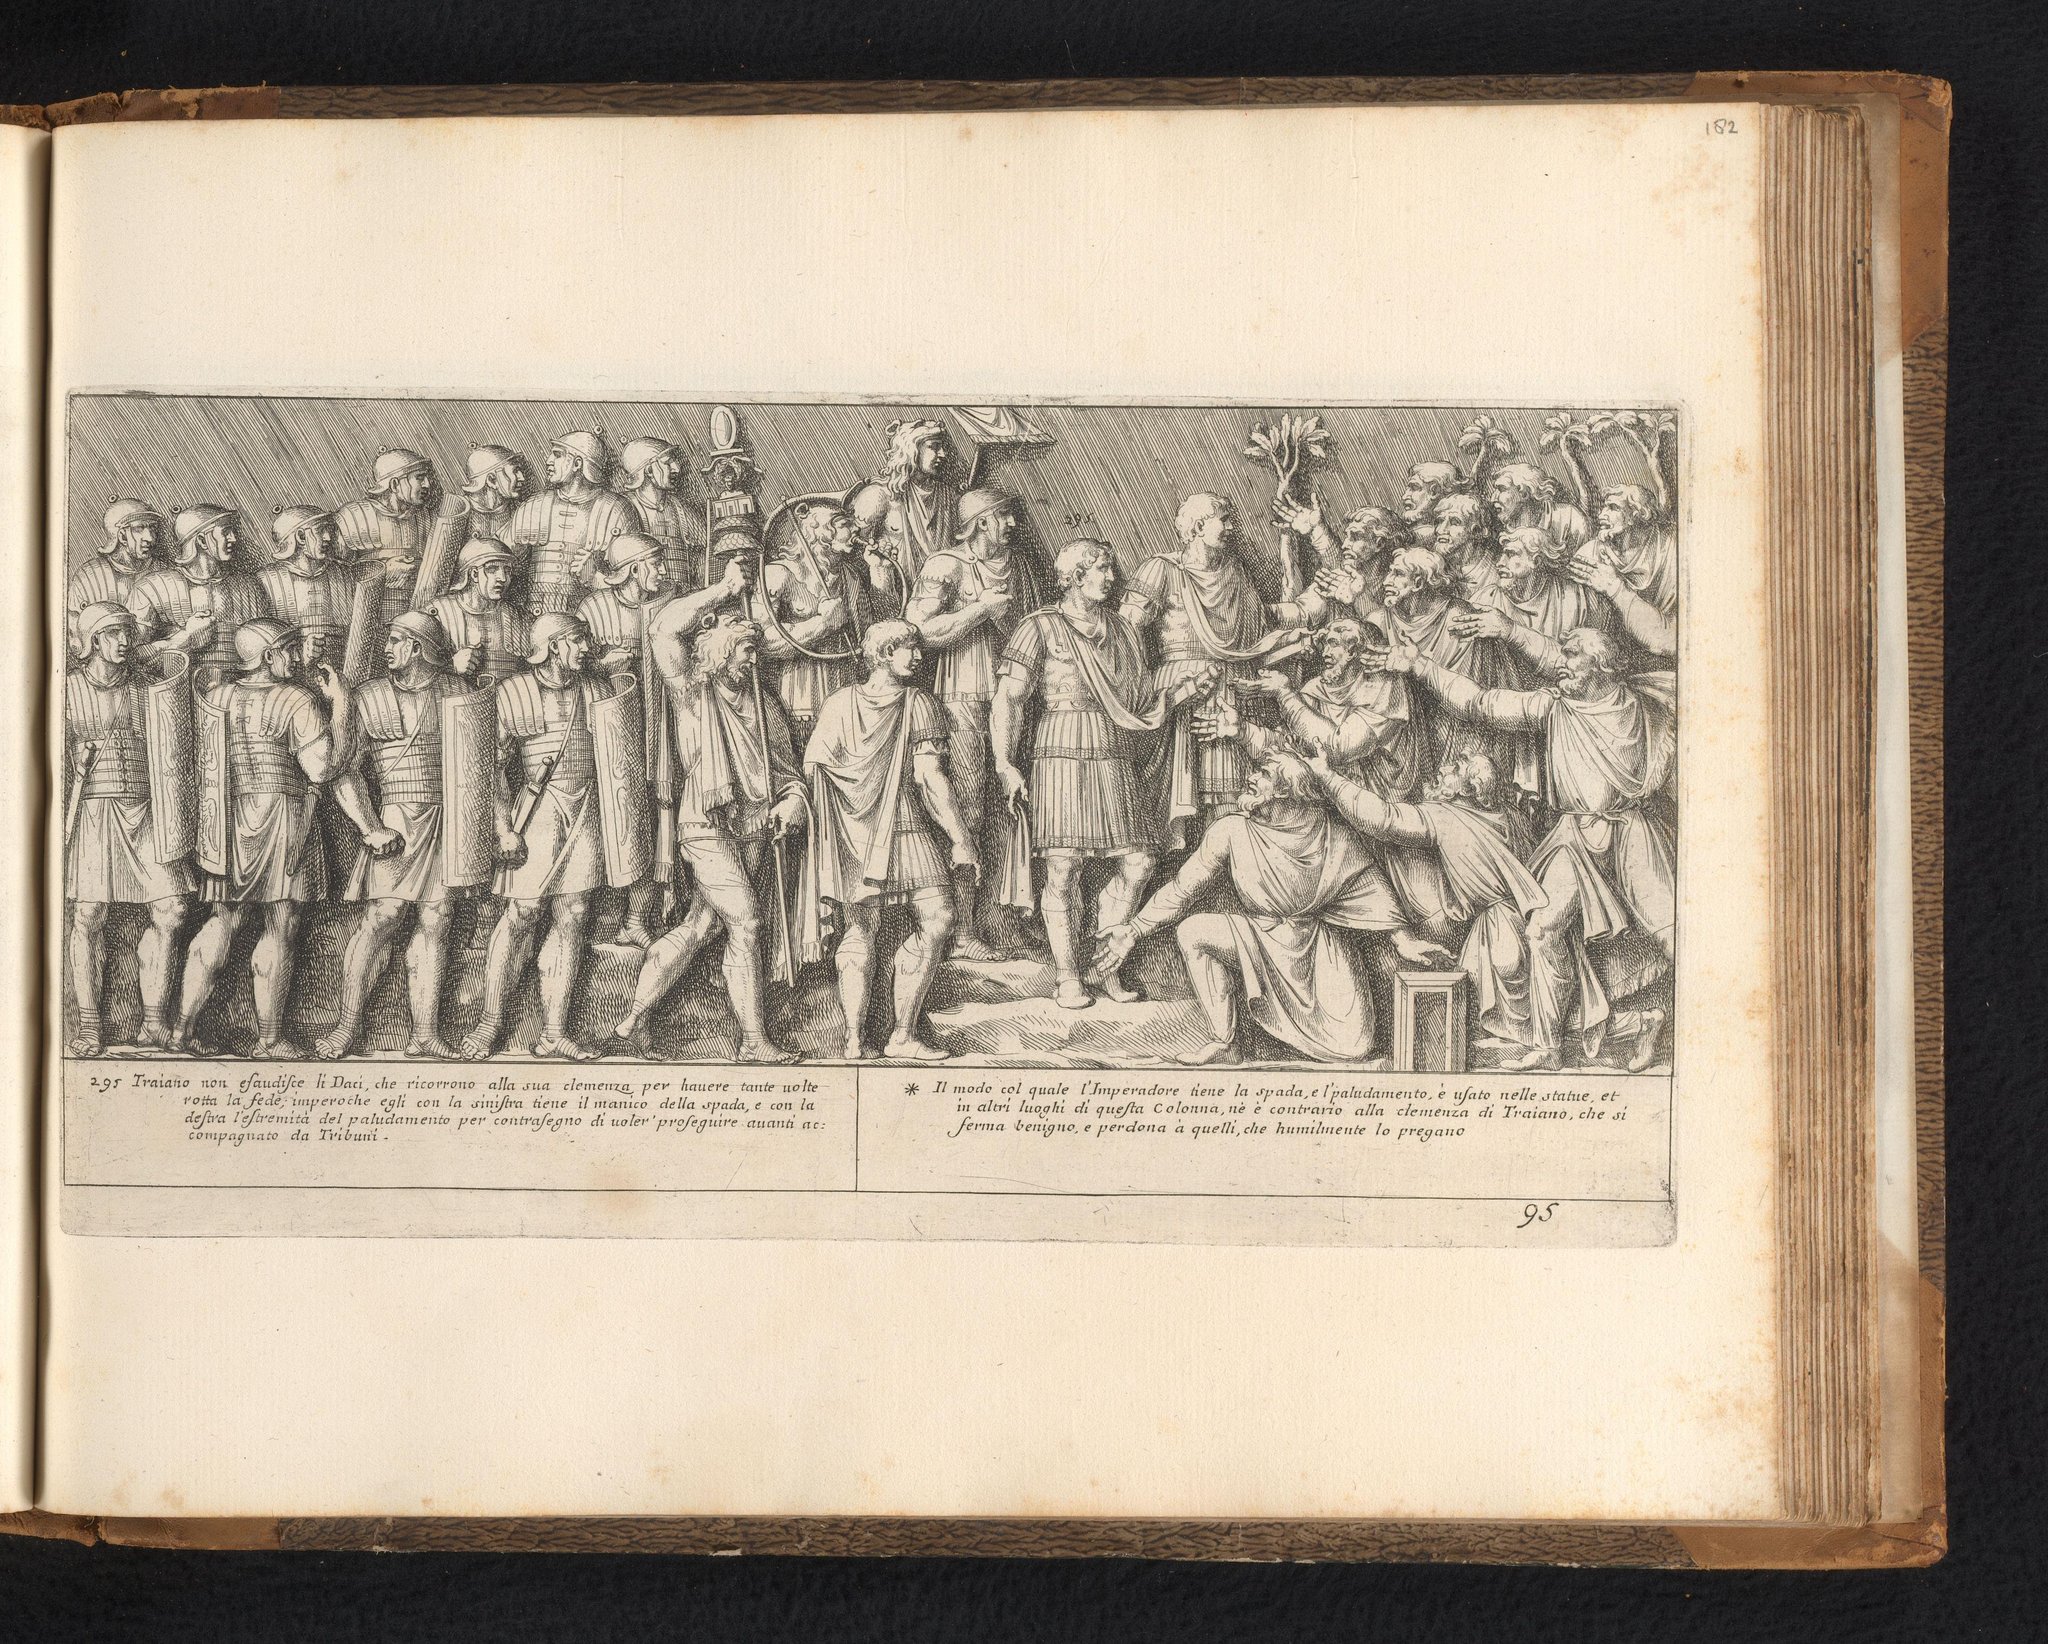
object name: album leaf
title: Colonna Traiana eretta dal senato, e popolo Romano all' imperatore Traiano Augusto nel suo foro in Rom (...)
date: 1637-1691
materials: paper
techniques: etching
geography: rome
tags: triumphal column with helical friezes, piece of sculpture, reproduction of a piece of sculpture, the soldier; the soldier's life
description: Detail van het spiraalvormige gebeeldhouwde fries op de Zuil van Trajanus. Het fries toont de oorlogen tussen de Romeinen en de Daciërs. Verklarende nummers in de ondermarge. Prent maakt deel uit van een album.